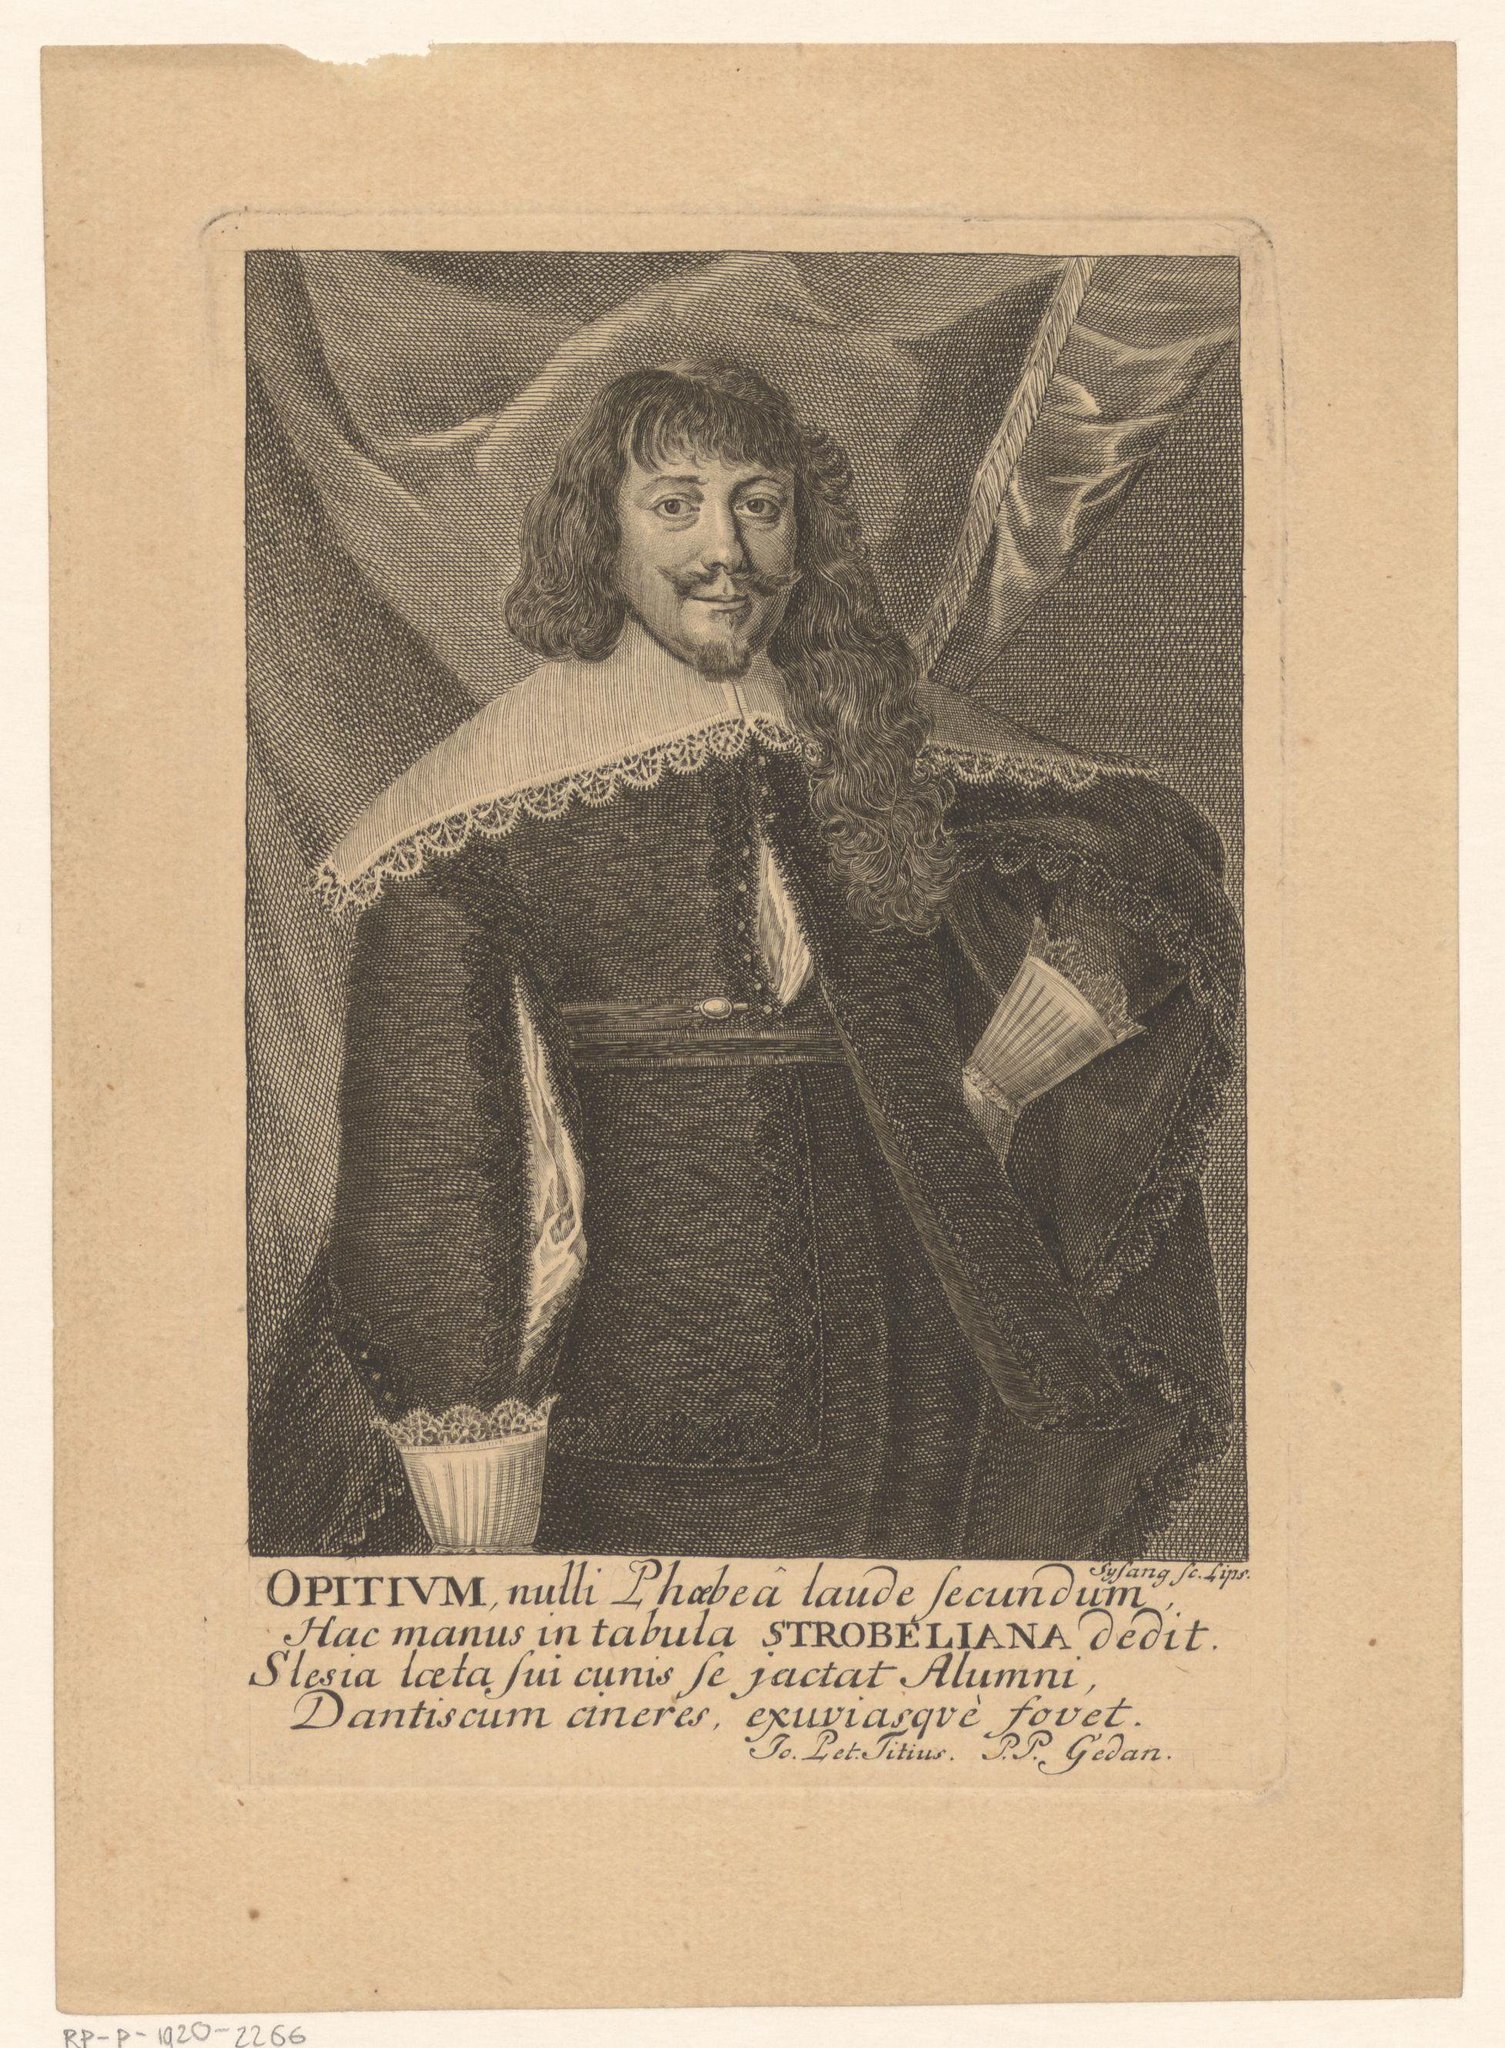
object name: print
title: Portret van Martin Opitz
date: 1739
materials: paper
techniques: engraving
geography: leipzig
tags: poland, martin opitz, historical persons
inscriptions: collector's mark: Lugt 2228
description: Prent gebruikt voor de publicatie: Gottsched, Johann Christoph. Lob- und Gedächtnißrede auf den Vater der deutschen Dichtkunst Martin Opitzen von Boberfeld. Leipzig: Bernhard Christoph Breitkopf, 1739.